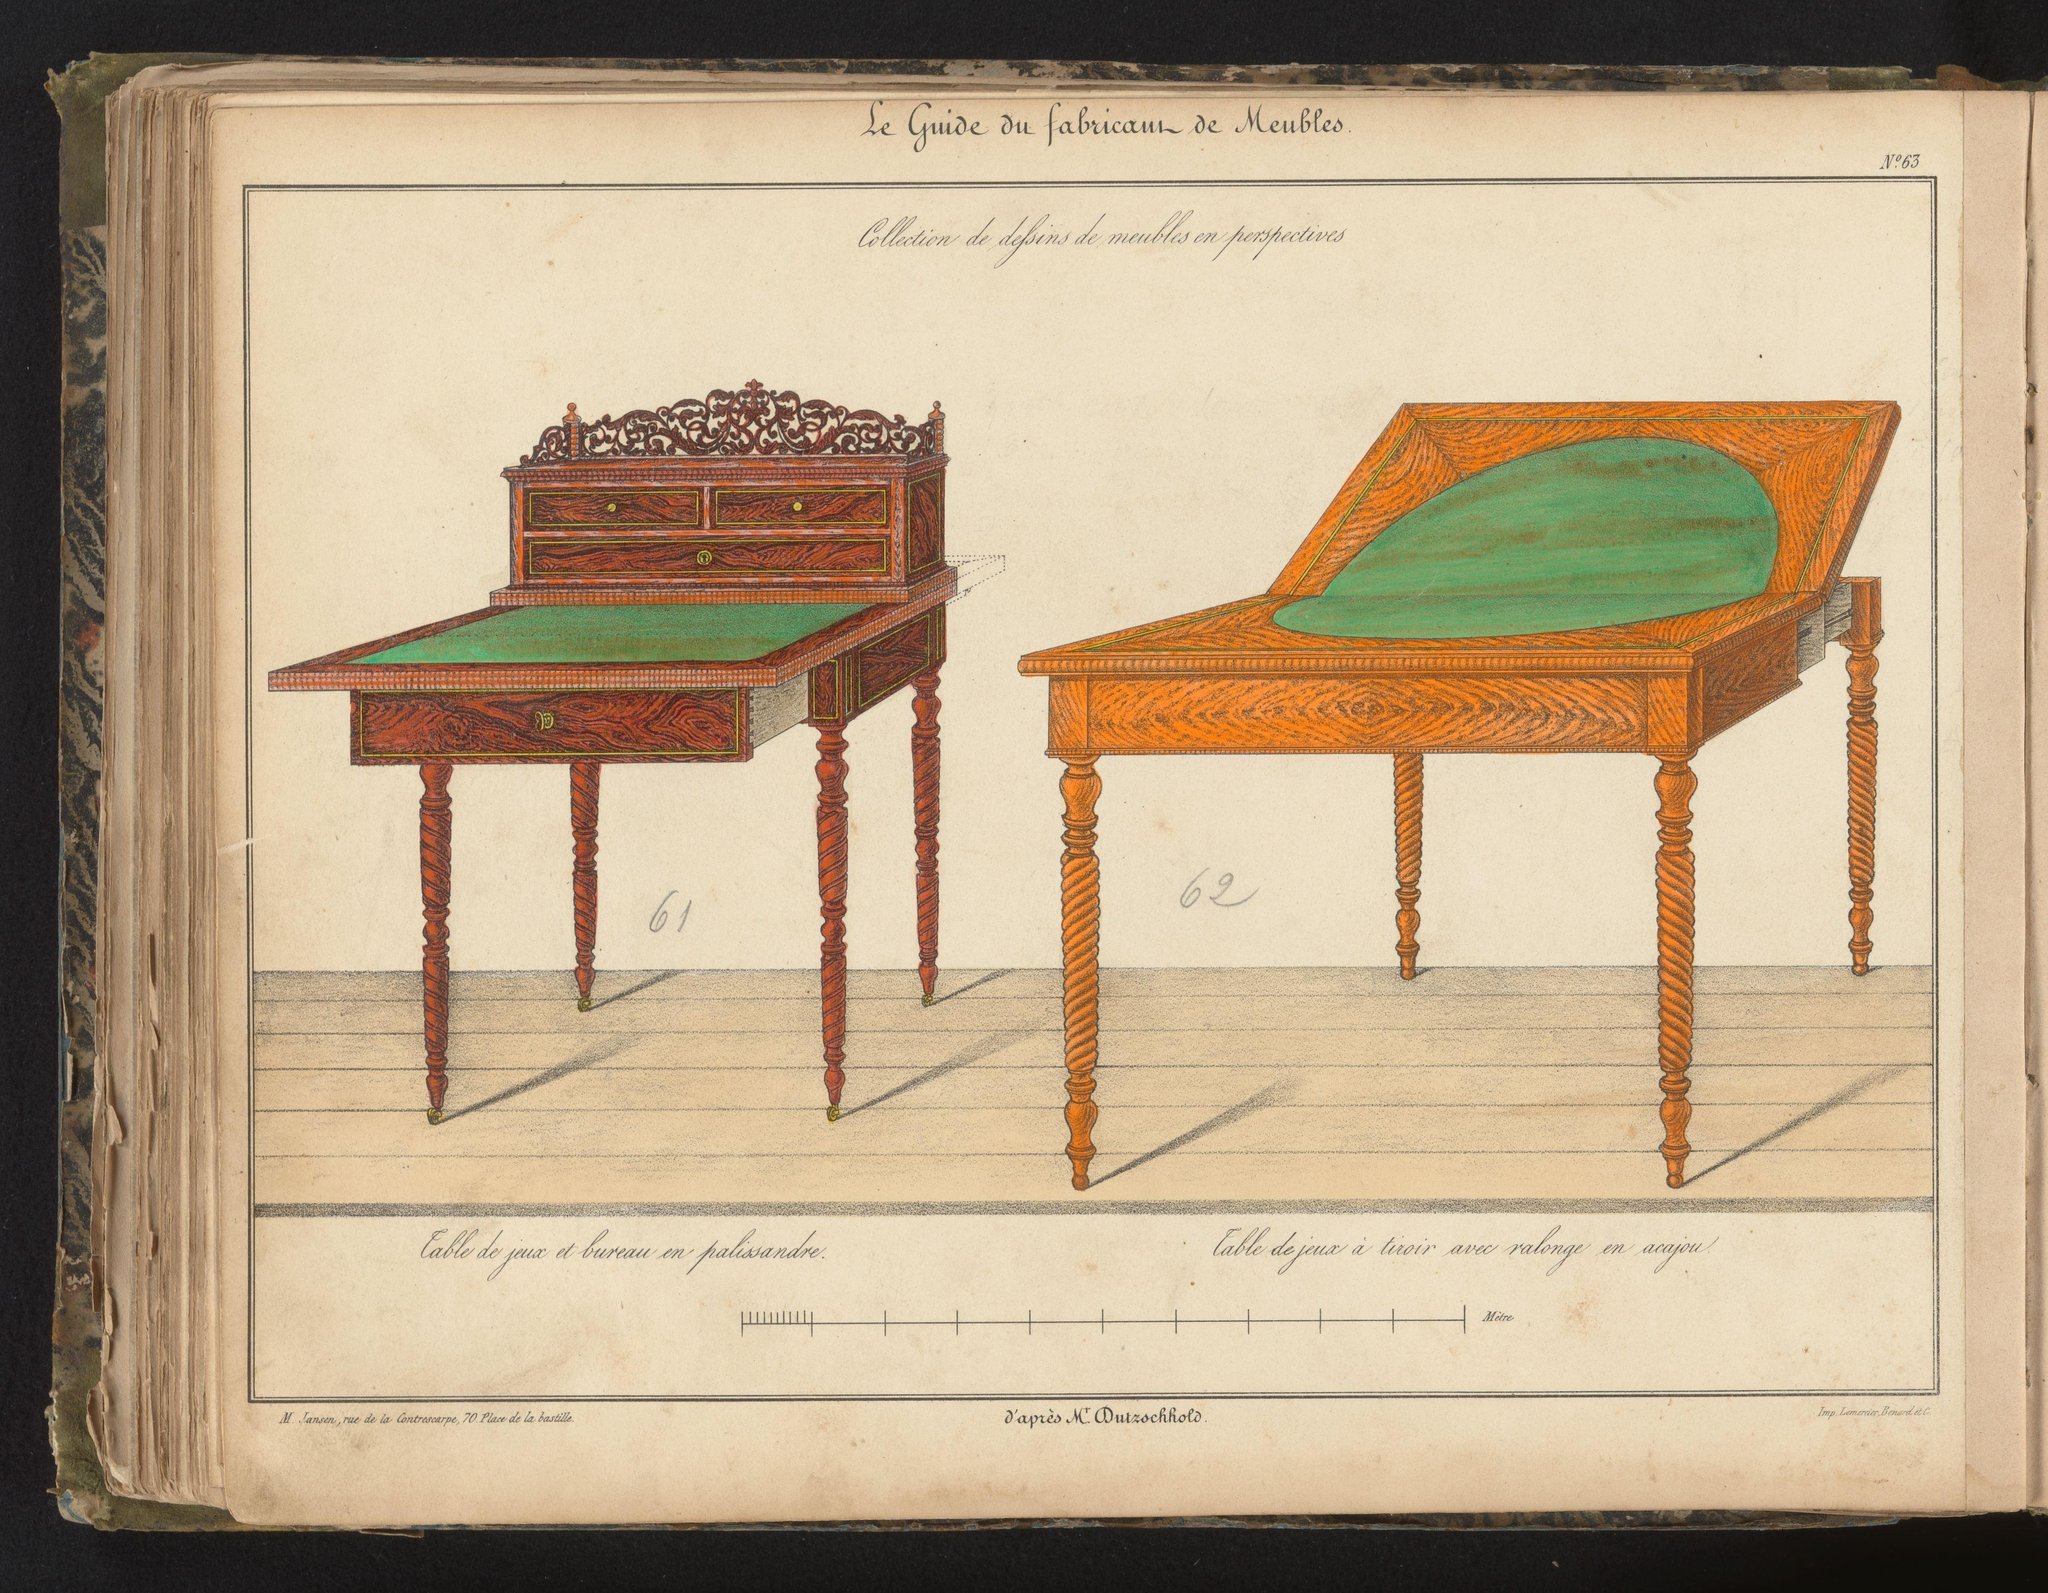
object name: print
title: Prent met twee ontwerpen voor speltafels door Mr Dutzschhold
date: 1825-1840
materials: ink, paper, pencil, watercolor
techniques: brush, lithograph, pen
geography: paris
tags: table (+ wood and other phytogenic material), card games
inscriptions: inscription: ‘61 Bureau de Dame Table de jeux en palissandre 24p* ‘’…’’ acajou 62 Table de jeux à ‘’table coulisse pies à torsade ‘’…’’ tors ‘’…’’ cannelés’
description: Ingeplakte ingekleurde prent genummerd 63 met twee ontwerpen voor speltafels, één in palissanderhout met opstel, uitschuifbaar of opvouwbaar. Op de prent staat een schaalindicatie, het adres van de uitgever, de drukker en de ontwerper. Het blad op de achterzijde genummerd: 40, het tegenoverliggende blad met informatie over de afgebeelde meubelen genummerd: 40 bis. Onderdeel van een album met 80 bladen met tekeningen en een prent van gefineerde en gelakte meubelen, alsmede zitmeubelen.